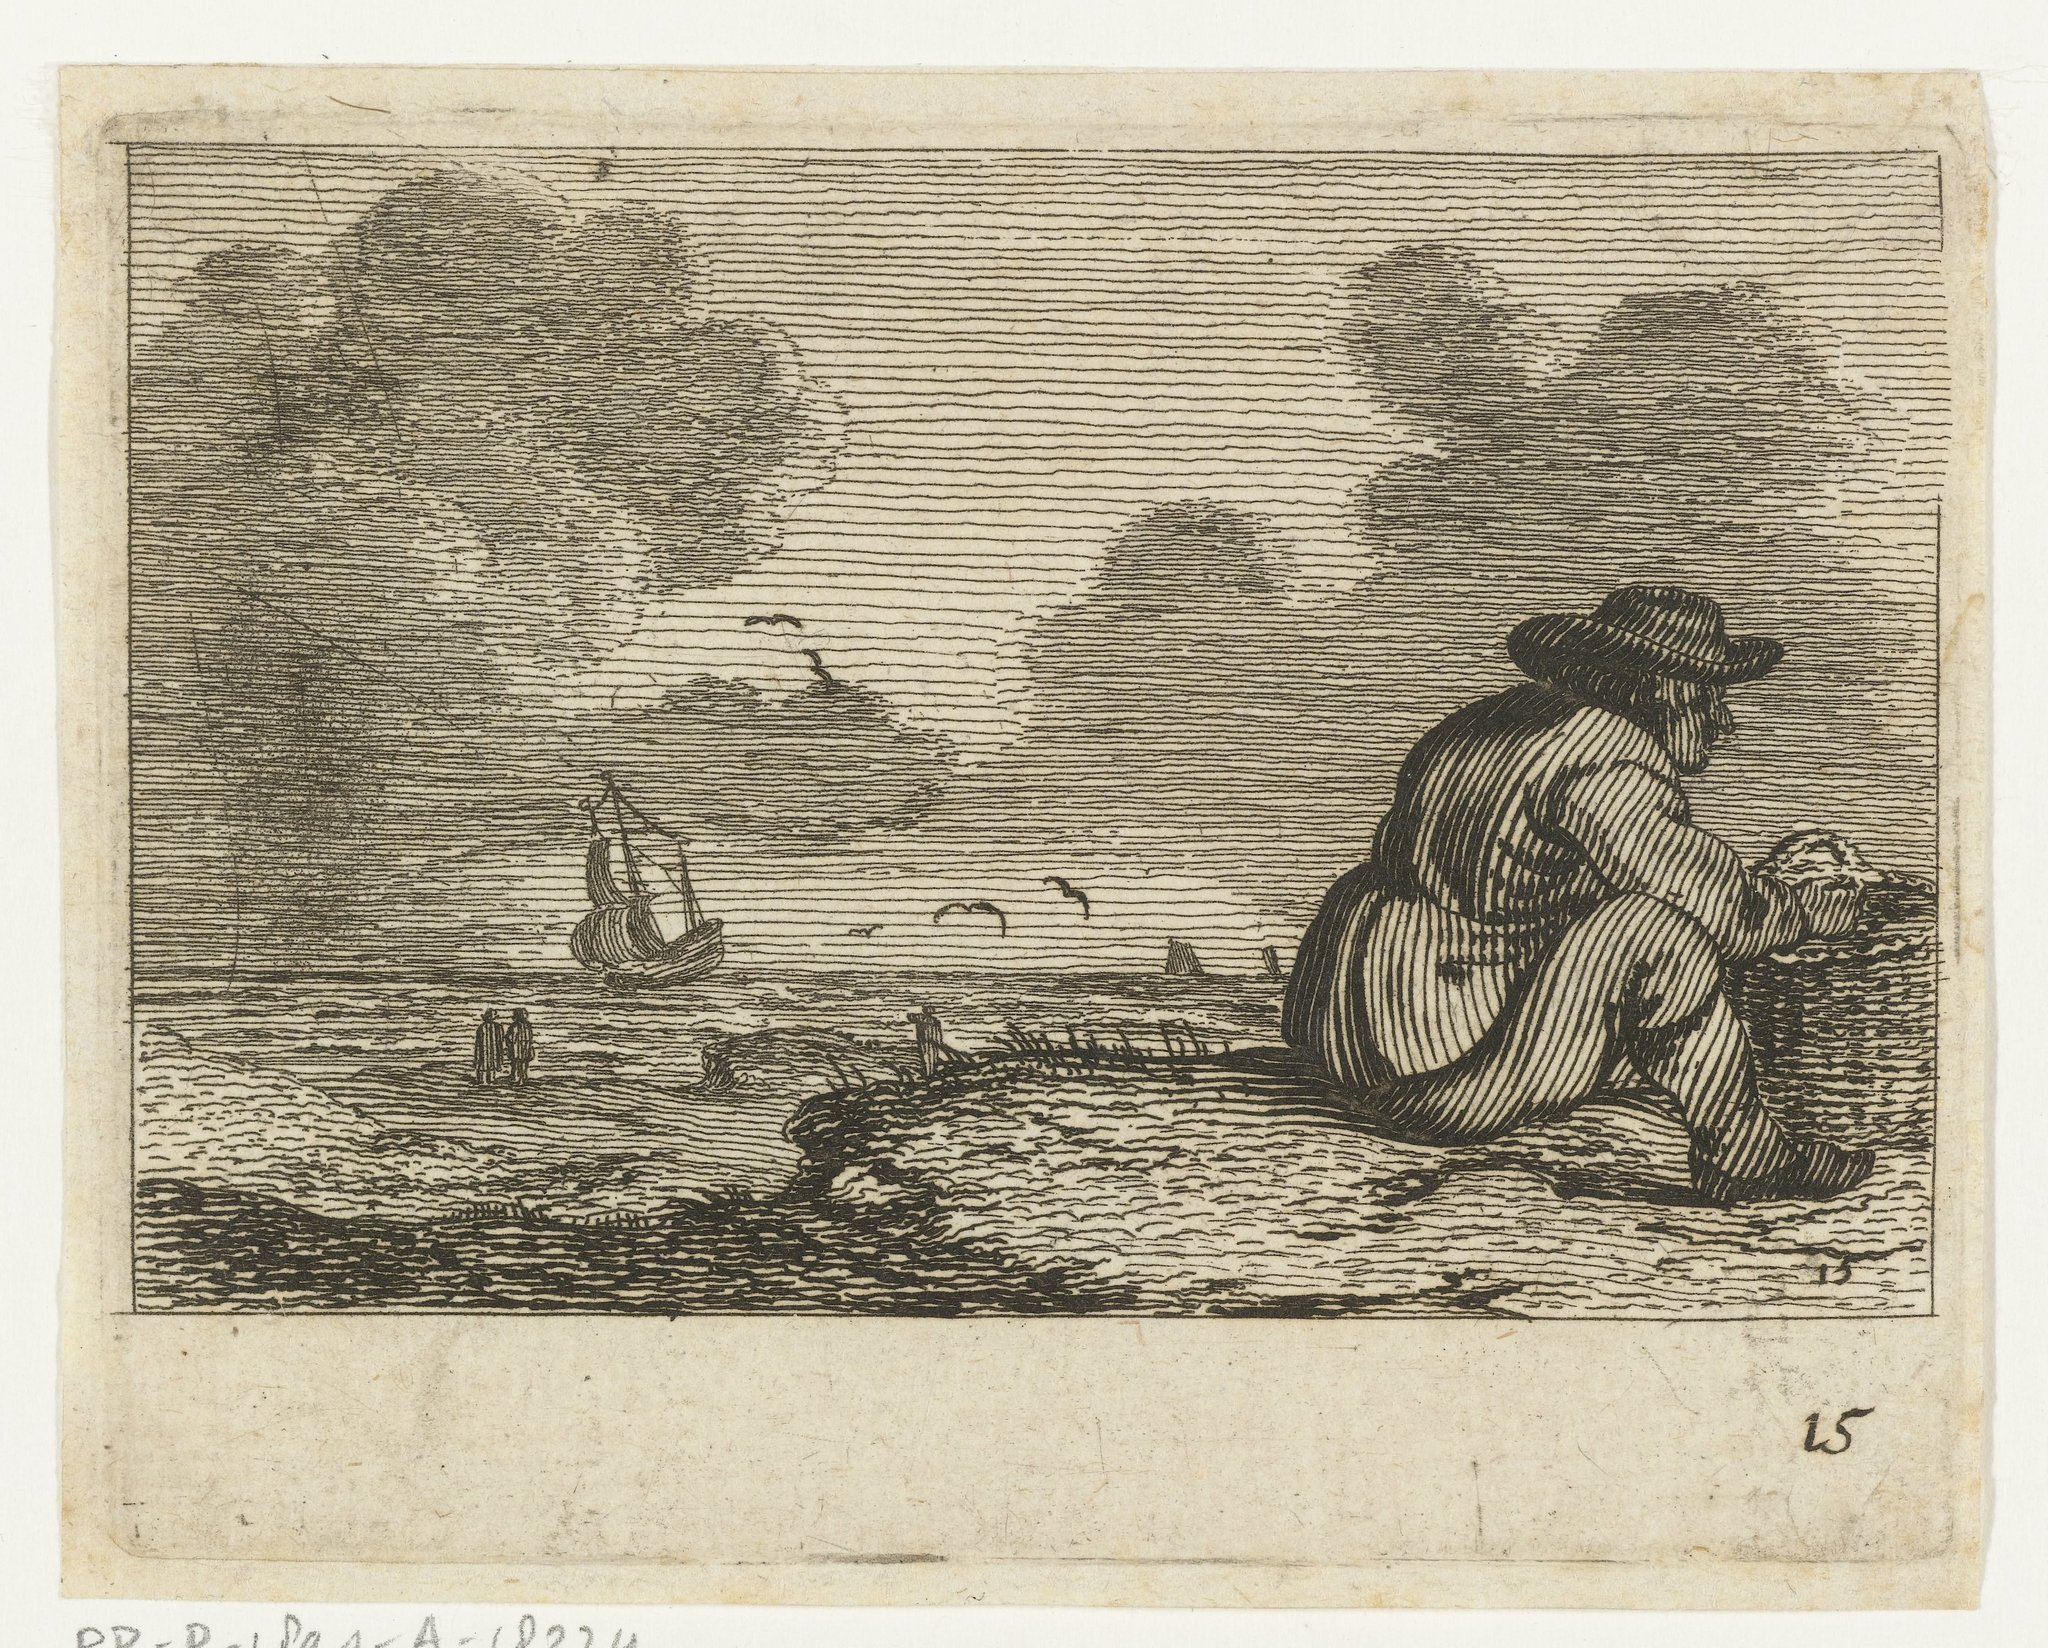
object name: print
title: Verscheyden Stranden en water gesichten gedaen door Jan Percelles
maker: gillis van scheyndel (i)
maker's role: draughtsman, print maker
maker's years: 1595-1660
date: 1645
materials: paper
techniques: etching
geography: northern netherlands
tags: dune coast, container made of plant material other than wood: basket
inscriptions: collector's mark: Lugt 2228